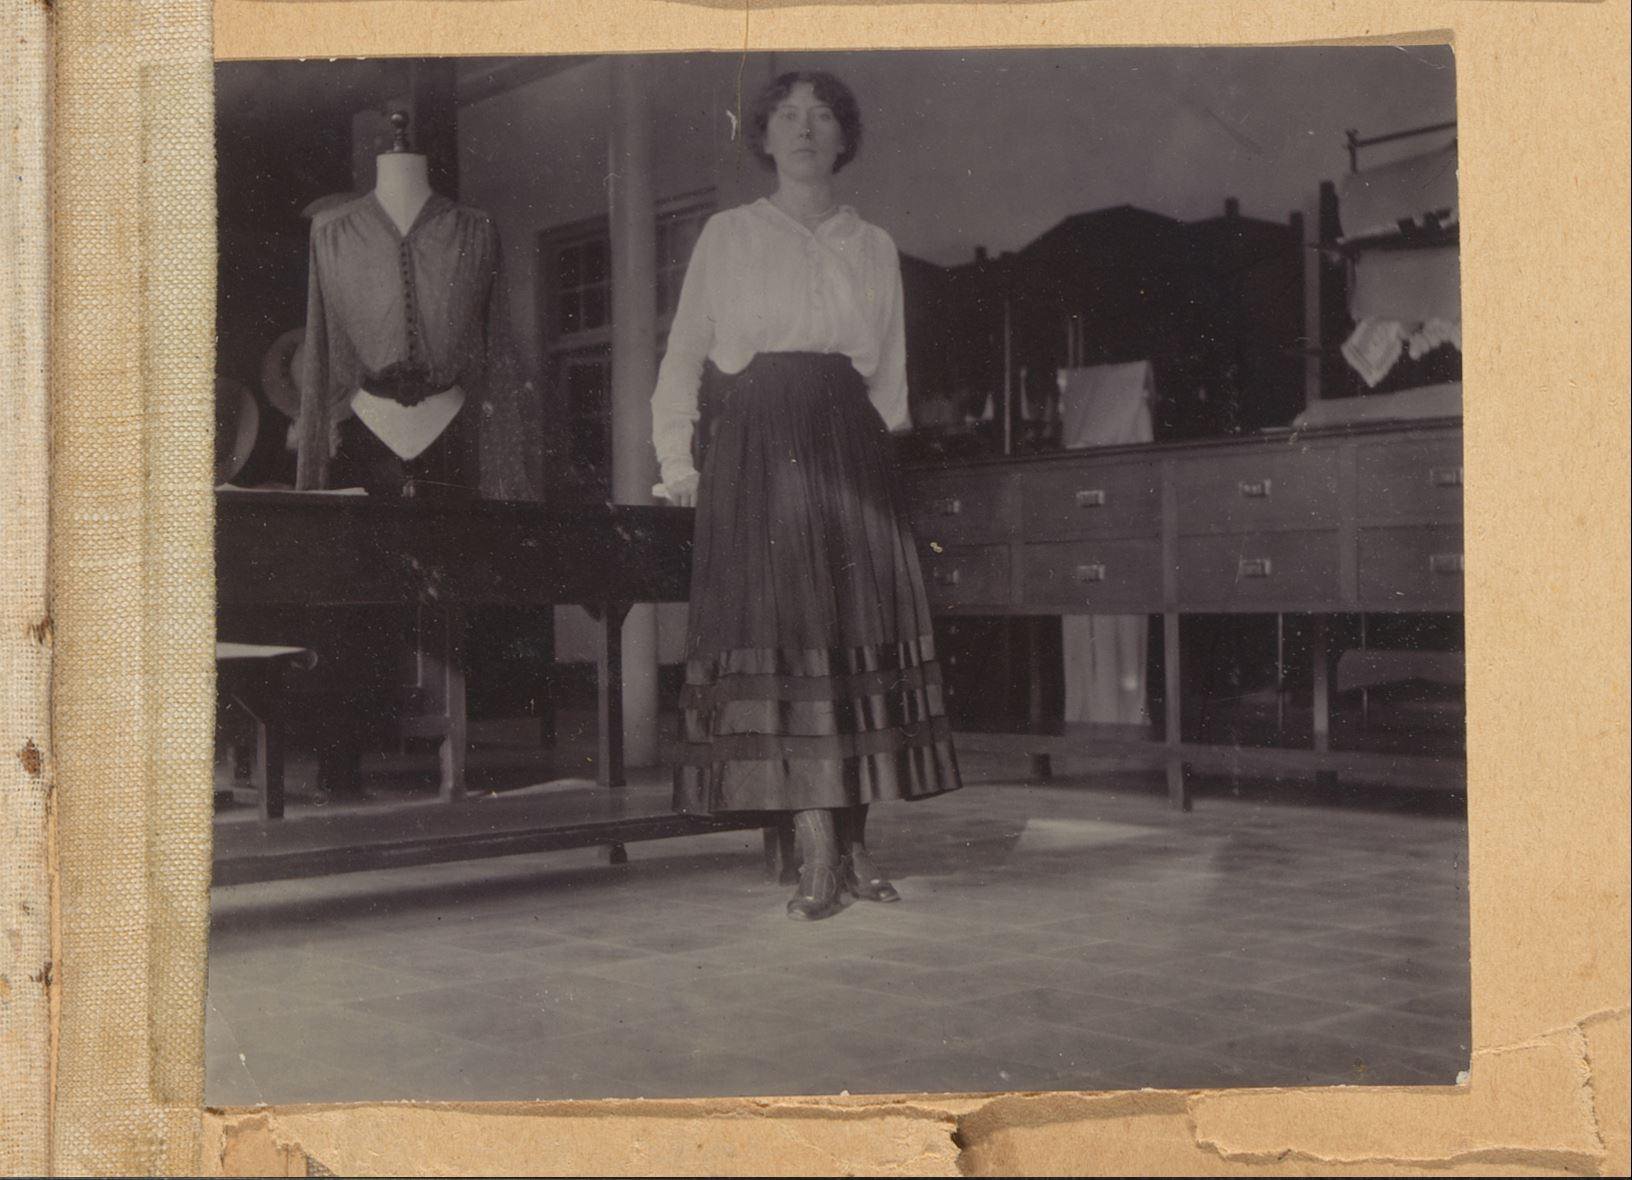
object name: photograph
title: Europese vrouw poserend naast paspop, vermoedelijk in Jogjakarta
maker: Anonymous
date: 1915-1920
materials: photographic support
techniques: gelatin silver print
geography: jogjakarta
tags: interior of the house, model, mannequin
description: Onderdeel van Familiealbum met foto's van een familie in de voormalige kolonie Nederlands-Indië en van een suikerfabriek in Purworejo.